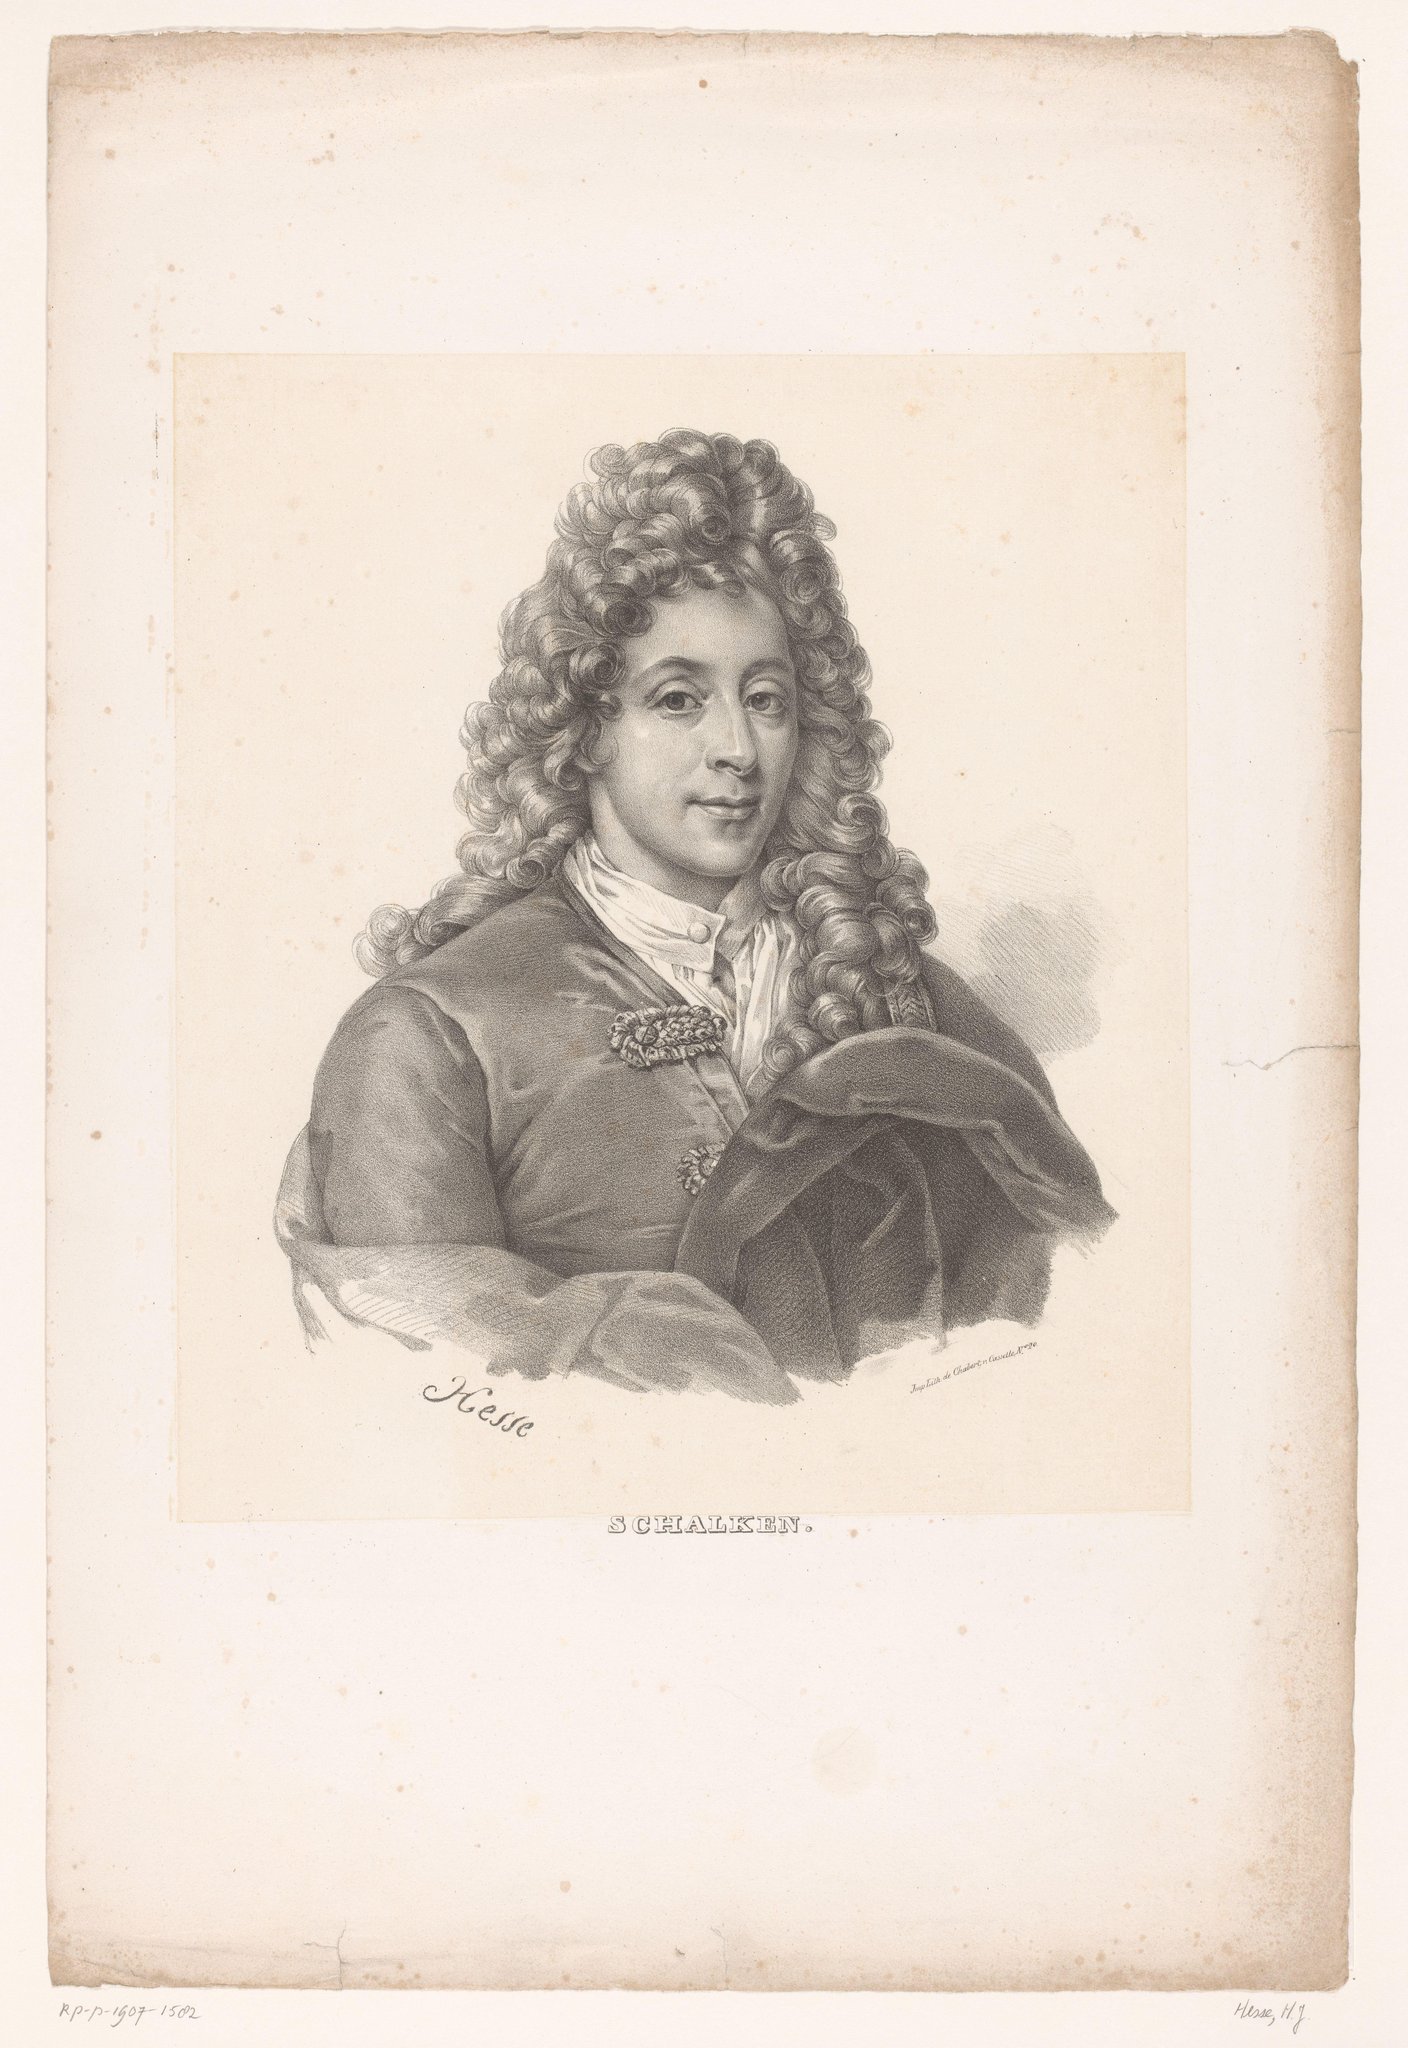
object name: print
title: Portret van Godfried Schalcken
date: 1822-1854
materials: paper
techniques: lithograph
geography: paris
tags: the hague, painter, print maker, draughtsman, godfried schalcken, historical persons, portrait, self-portrait of painter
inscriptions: collector's mark: Lugt 2228a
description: Prent waarschijnlijk ook gebruikt in: Chabert, Jean Claude. Galerie des peintres ou collection de portraits des peintres les plus célèbres de toutes les écoles. Accompagnée d'une notice sur chacun d'eux, et de copies de dessins originaux / Galerie des peintres ou collection de portraits des peintres les plus célèbres de toutes les écoles. Accompagnée de leur notice historique, de leurs dessins et d'un discours sur les arts. Parijs: Jean Claude Chabert, s.a. [1822-1834]. De samenstelling van tegenwoordig bekende en al dan niet gebonden exemplaren van deze uitgave verschillen. Dit omdat de prenten en bijhorende stukken tekst op inschrijving en waarschijnlijk ook los verkrijgbaar waren.